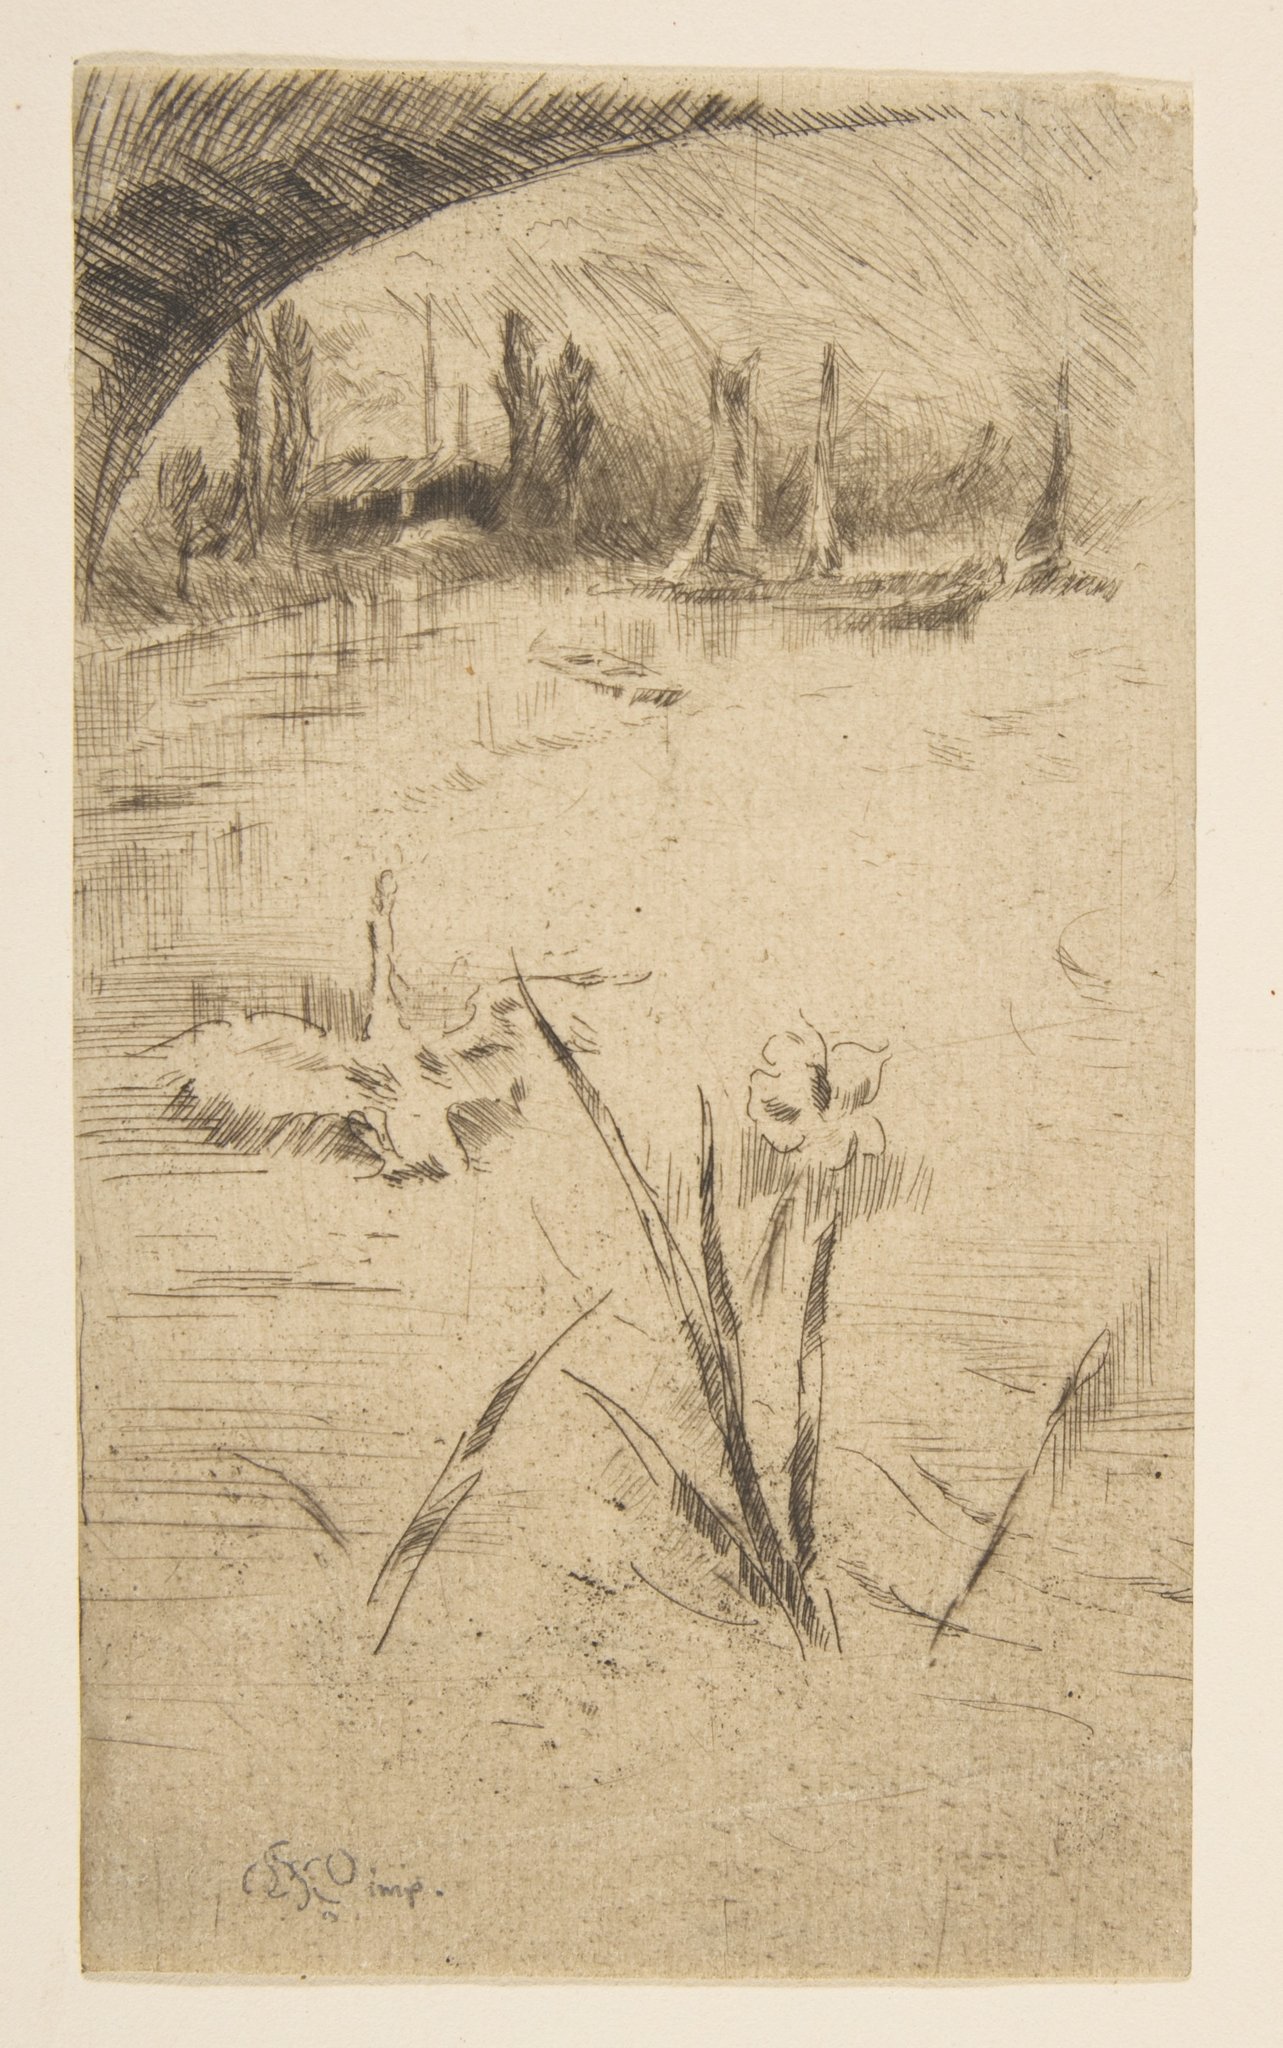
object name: print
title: Swan and Iris (Sketch after Cecil Lawson's "Swan and Iris")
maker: james mcneill whistler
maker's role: artist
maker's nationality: american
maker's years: 1834-1903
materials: ink, paper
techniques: etching, printing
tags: swans,flowers